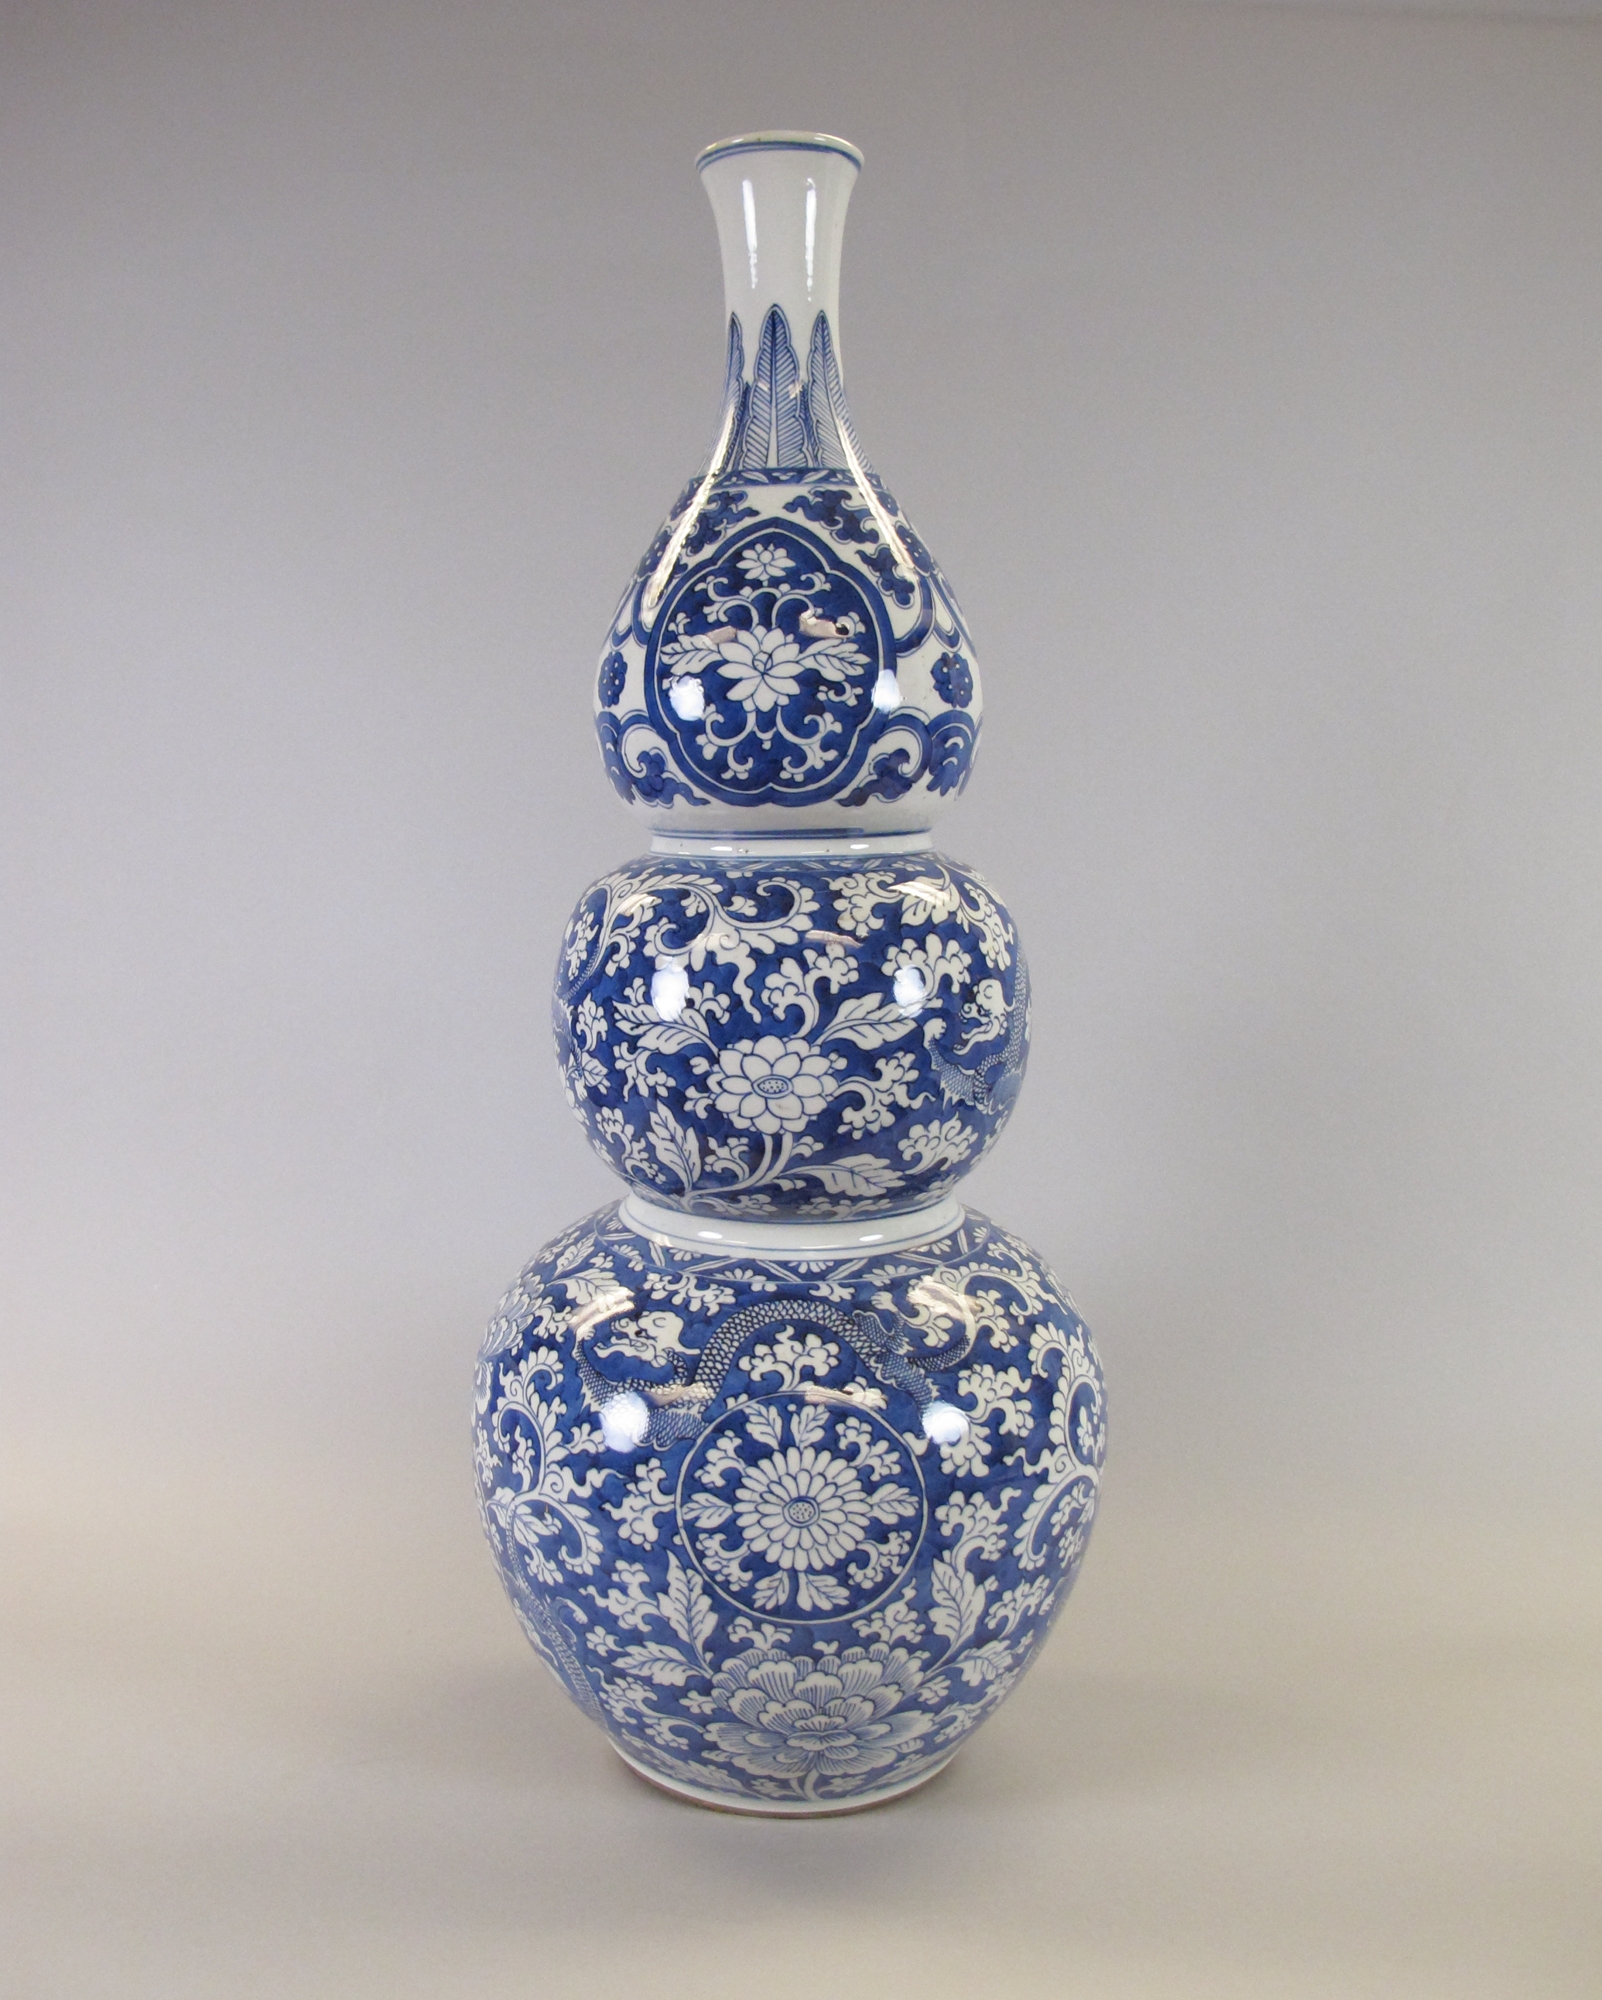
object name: vase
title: Triple gourd vase with dragon and flowers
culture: chinese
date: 1667-1733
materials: cobalt, porcelain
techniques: painting, underglaze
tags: flowers